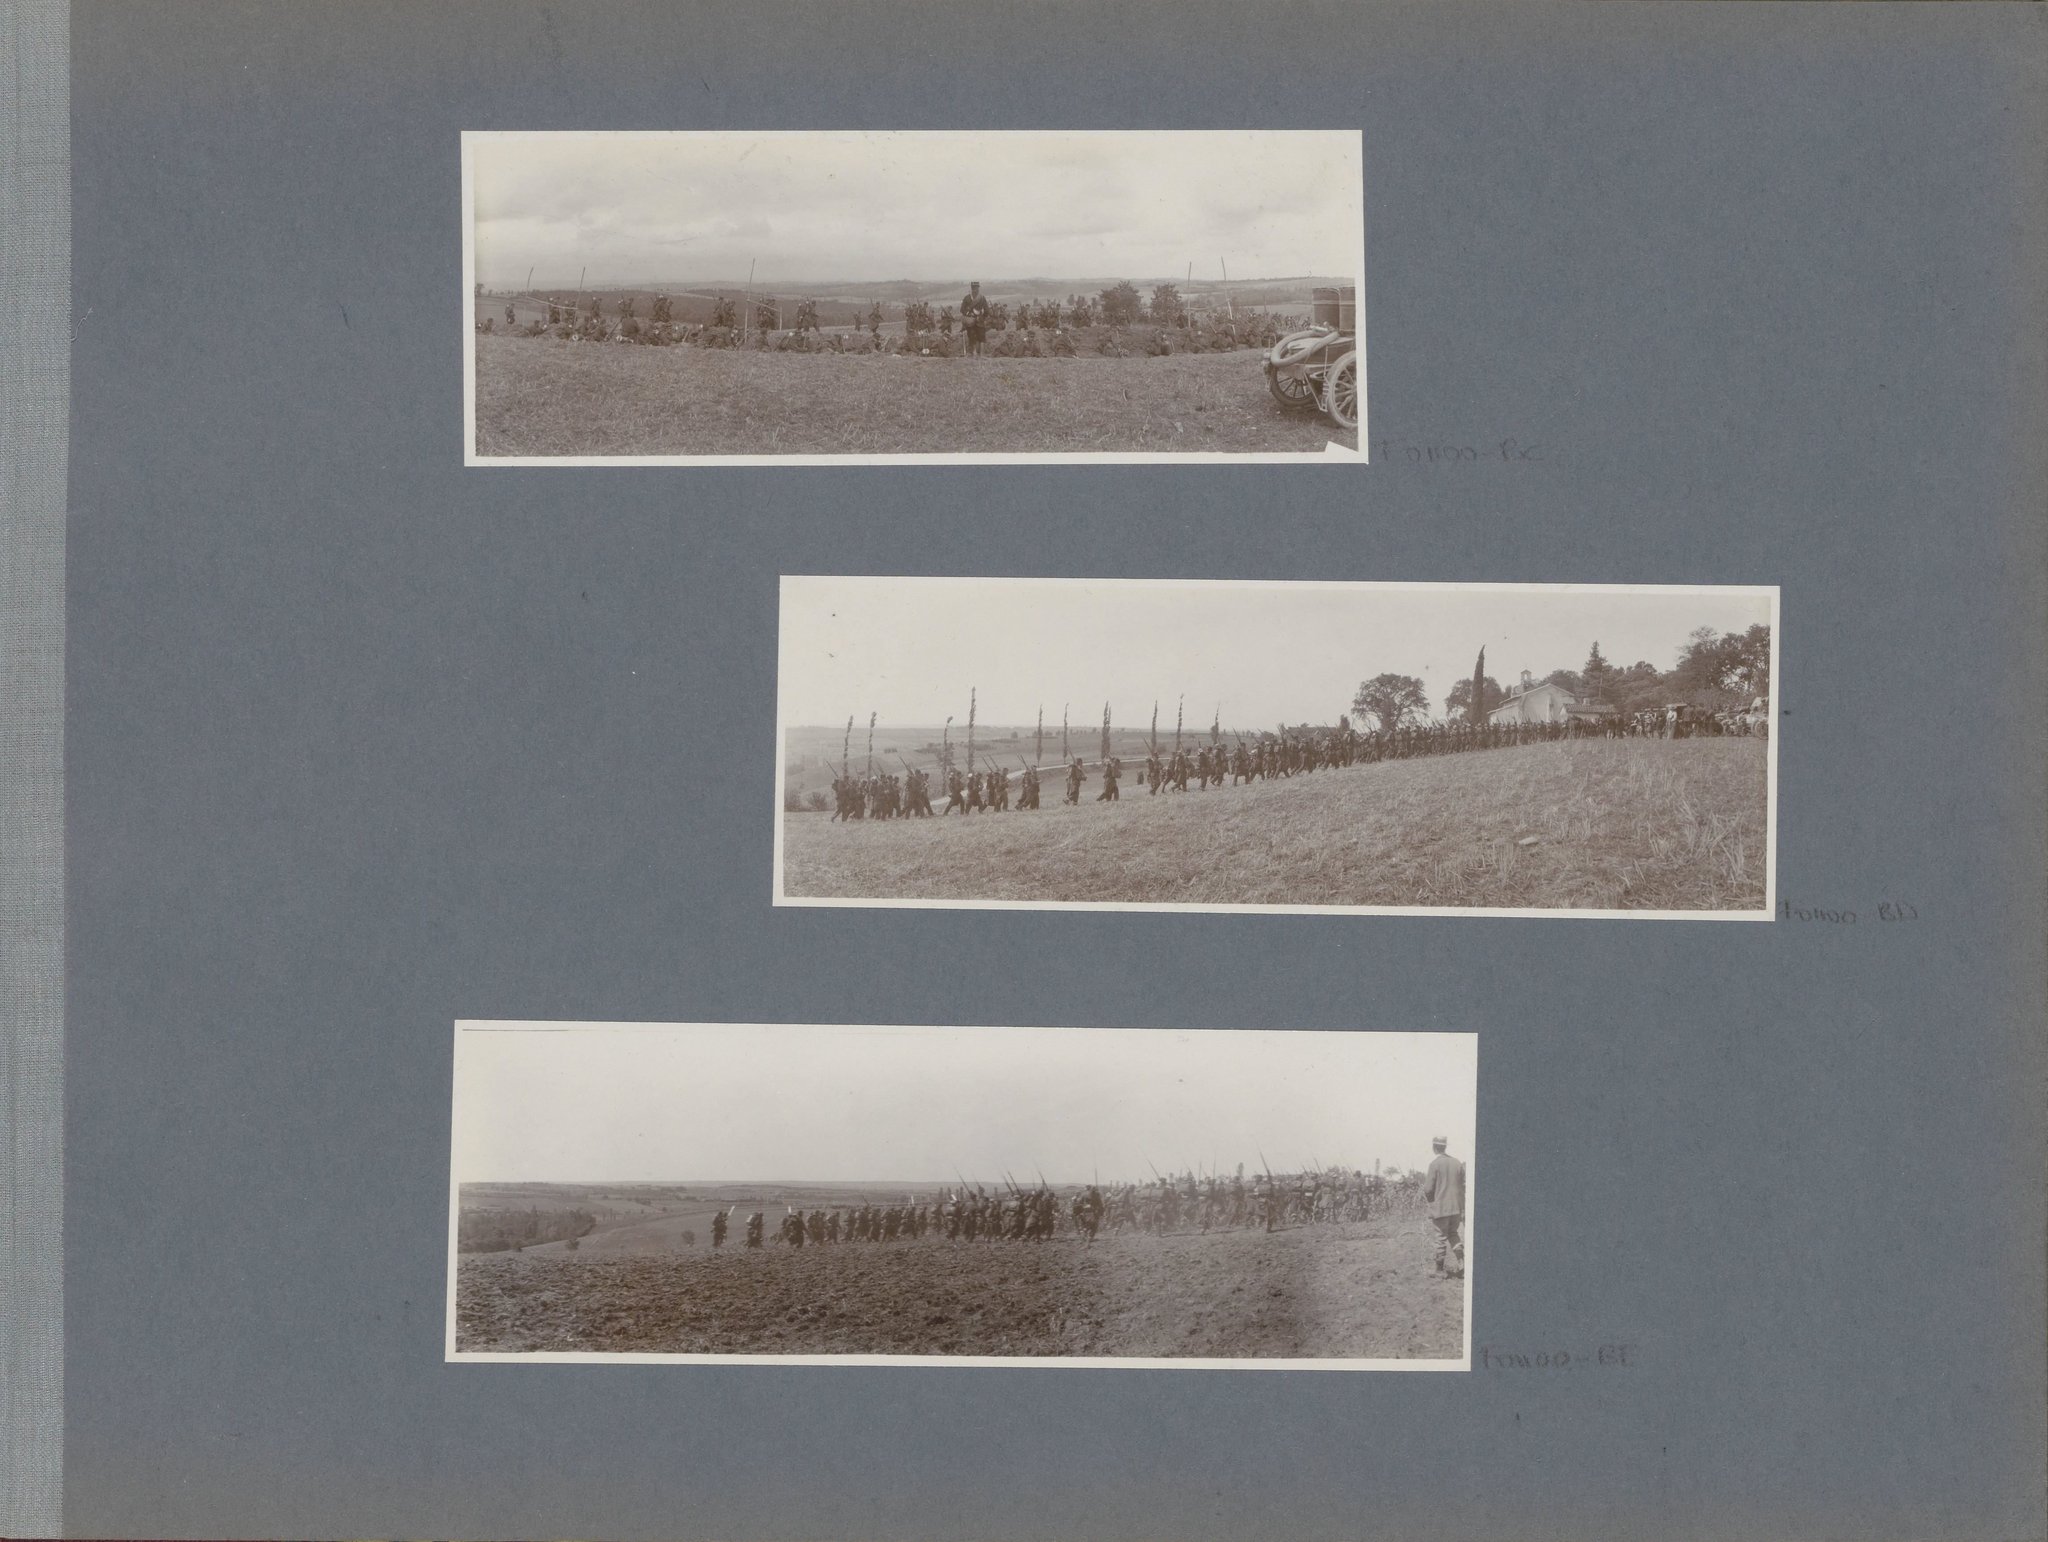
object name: photograph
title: Militairen in een stelling in Frankrijk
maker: Anonymous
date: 1902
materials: paper, photographic support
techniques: daylight paper print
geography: france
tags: trenches (+ land forces), manoeuvre ~ military training, defensive measures (military) (+ land forces), france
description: Onderdeel van Fotoalbum van een legeroefening in Zuidwest-Frankrijk in 1902.